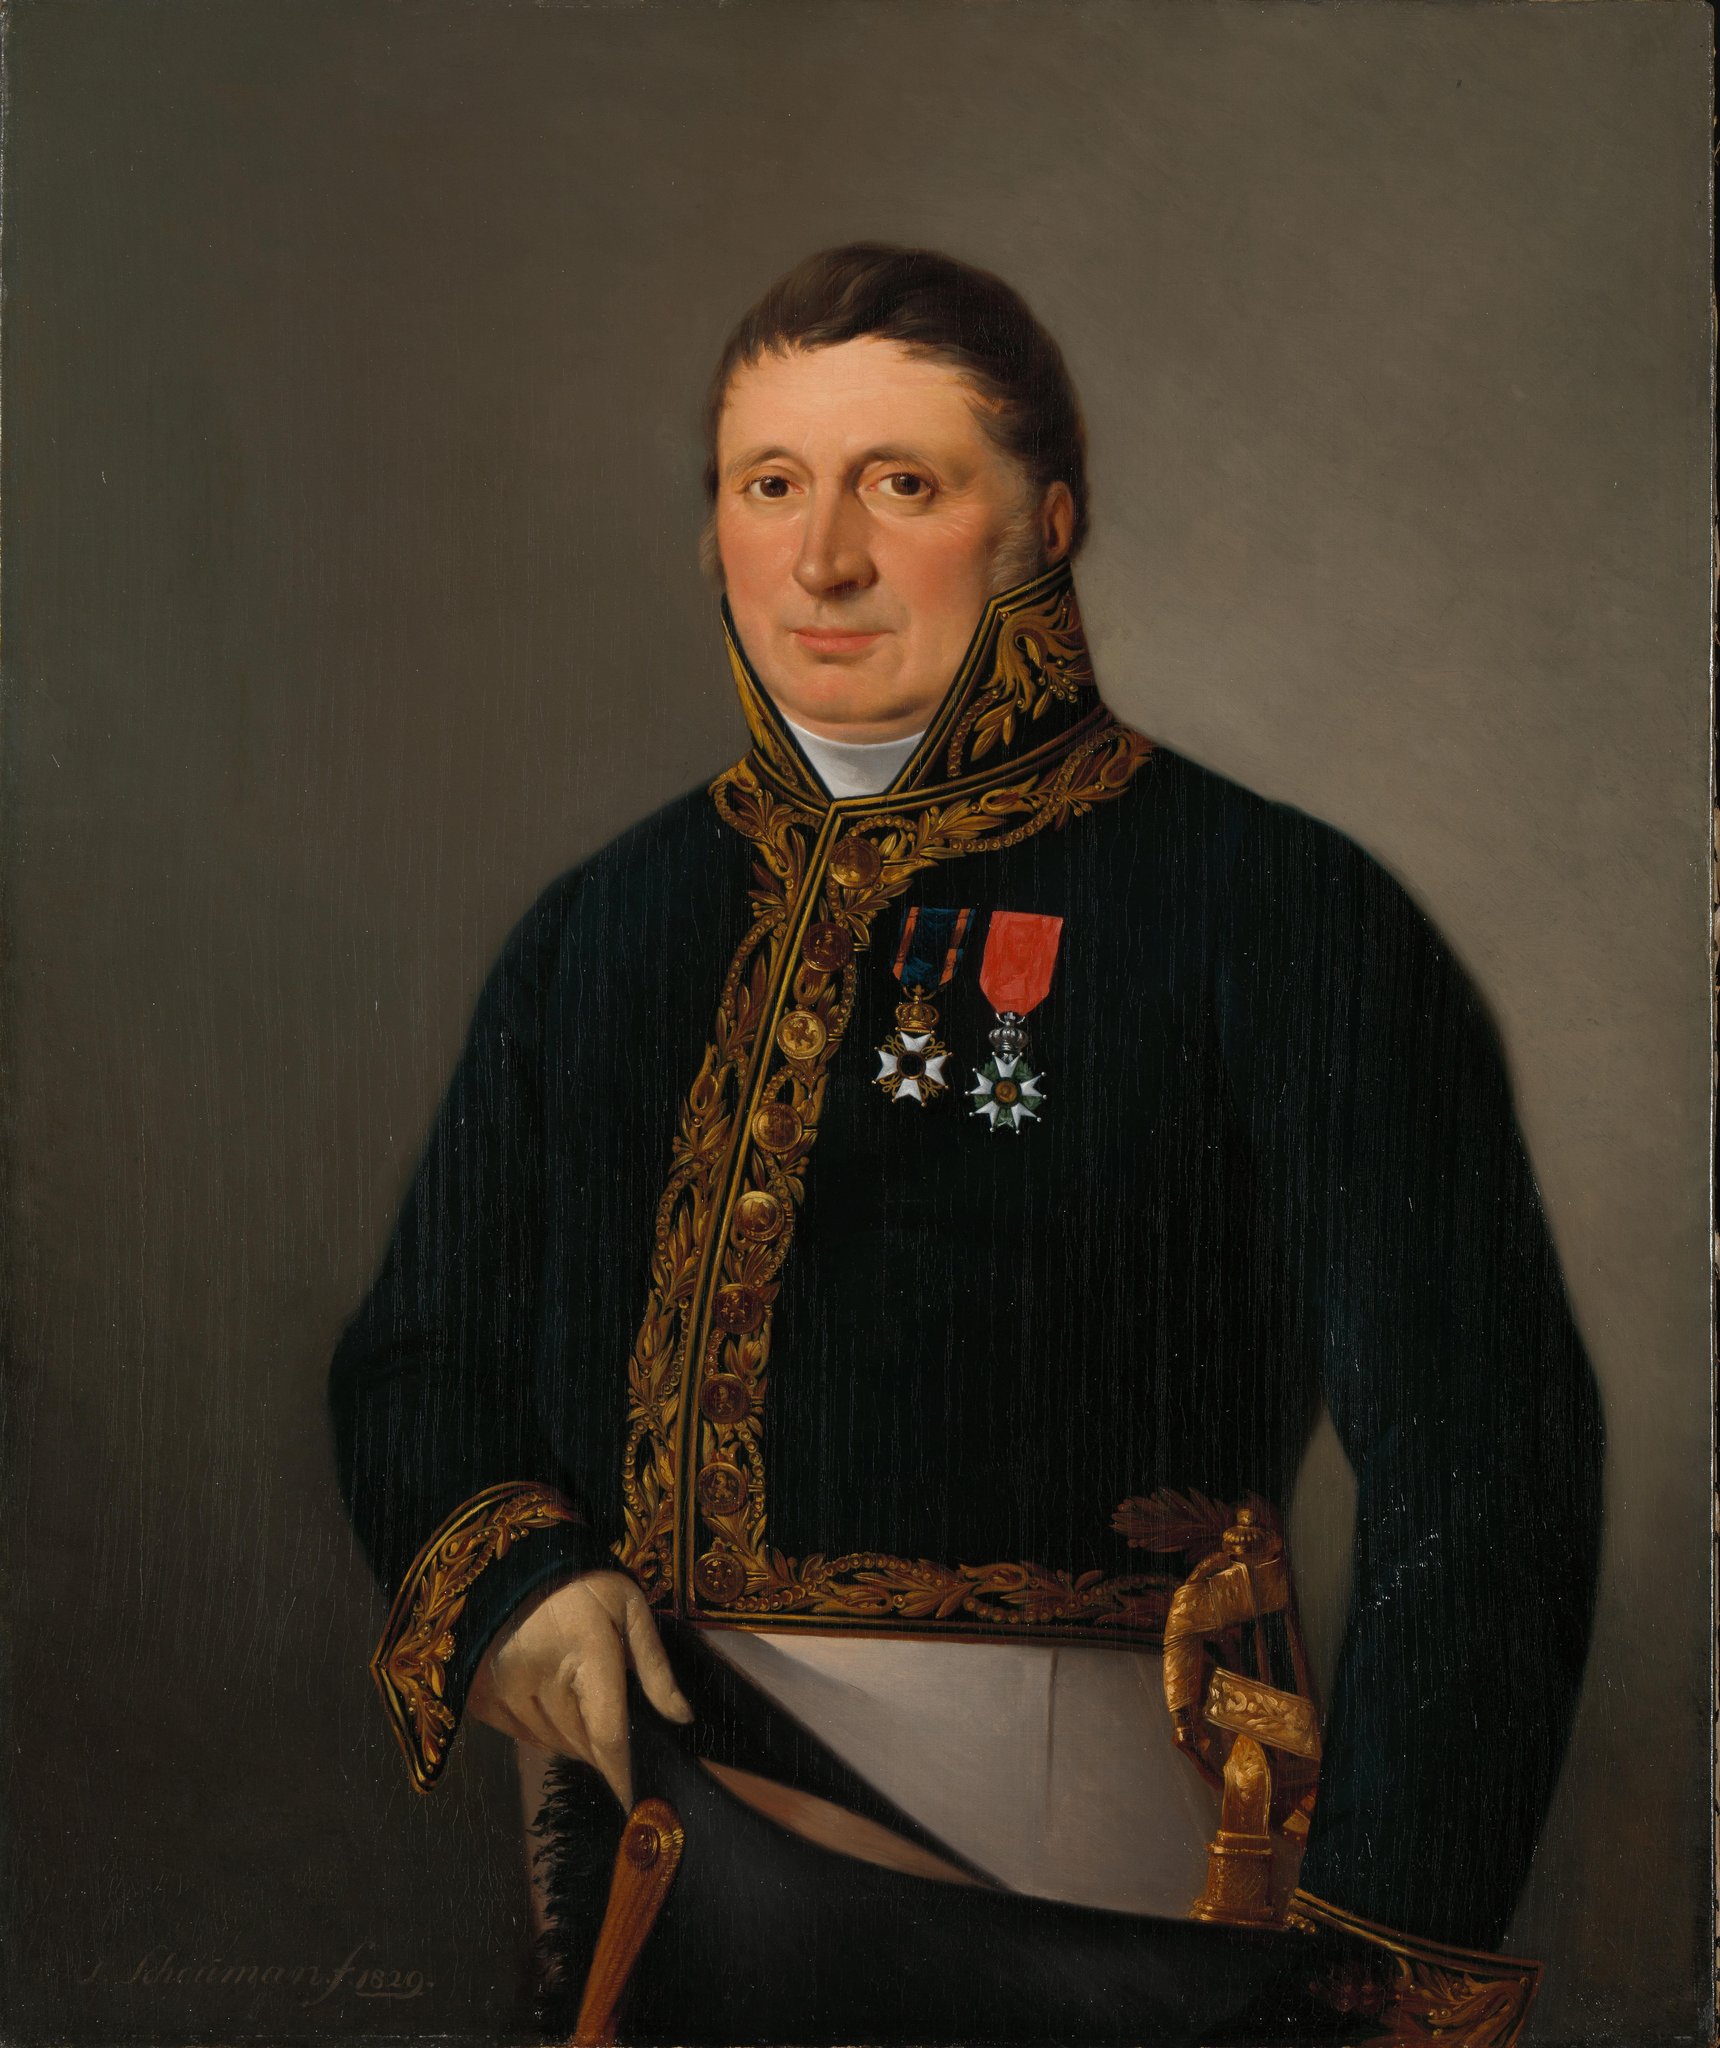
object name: painting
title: Portrait of Inspector-General A.F. Goudriaan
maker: izaak schouman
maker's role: draughtsman, painter, print maker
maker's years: 1801-1878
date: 1829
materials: canvas, oil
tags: historical persons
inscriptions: date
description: Adriaan François Goudriaan, by Izaak Schouman, 1829. After 1800 the water authority administration was radically centralised. In 1808 it was decided to divide the country into two water-authority districts. Adriaan François Goudriaan (1768-1829) was appointed inspector general of the northeast district. It was his initiative to introduce the 'Amsterdamsch Peil': a standard water level for the whole country. Goudriaan is portrayed in his official uniform. He is wearing two insignias. One was received from the French emperor Napoleon, the other from King William I. Goudriaan served both rulers as a civil servant: the various changes of regime in the years after 1800 did not damage his career.